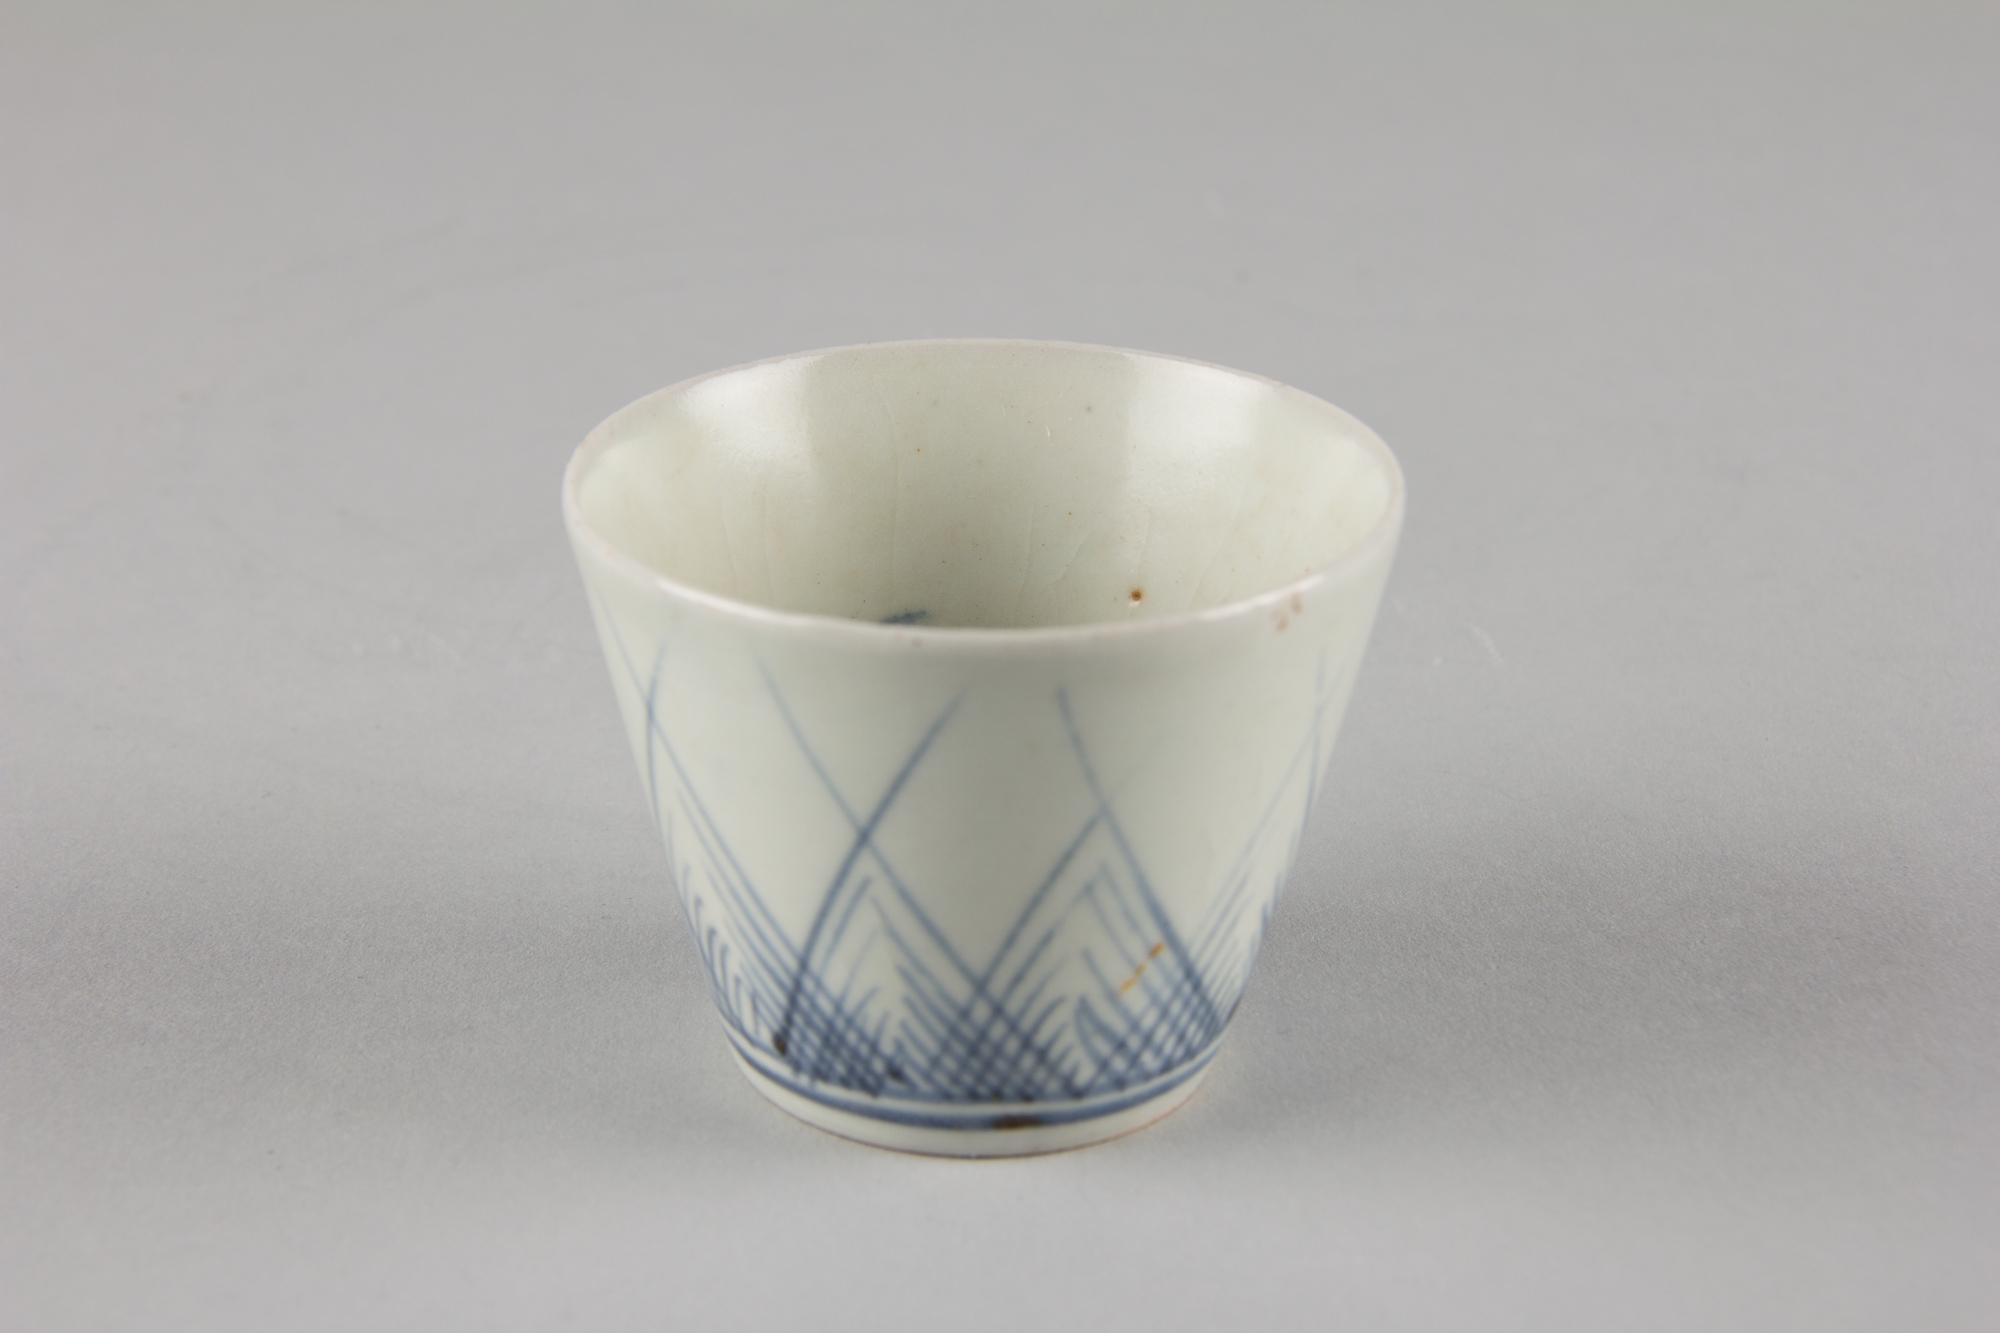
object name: soba cup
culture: japanese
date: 1734-1800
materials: porcelain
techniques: underglaze